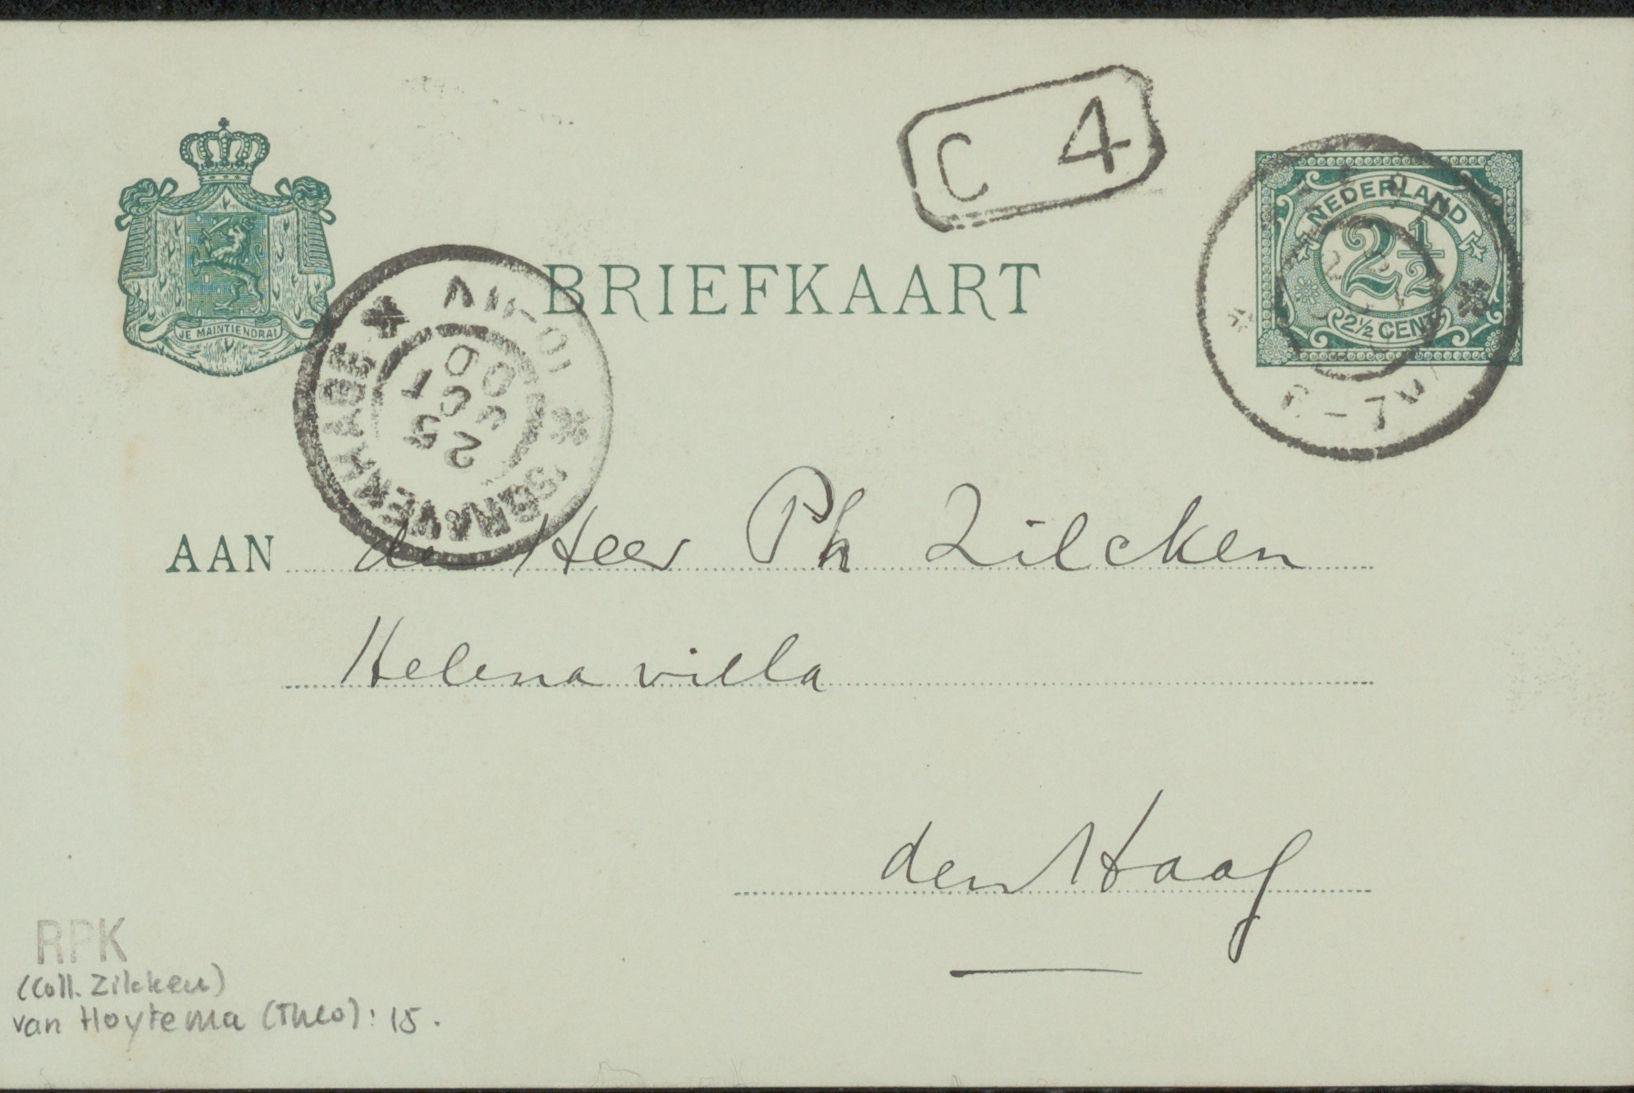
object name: postcard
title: Briefkaart aan Philip Zilcken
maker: theo van hoytema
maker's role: draughtsman, painter, print maker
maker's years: 1863-1917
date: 1900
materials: cardboard, ink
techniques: pen, writing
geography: weesp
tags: the hague, painter, draughtsman, philip zilcken, the graphic arts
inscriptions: collector's mark: ‘RPK’